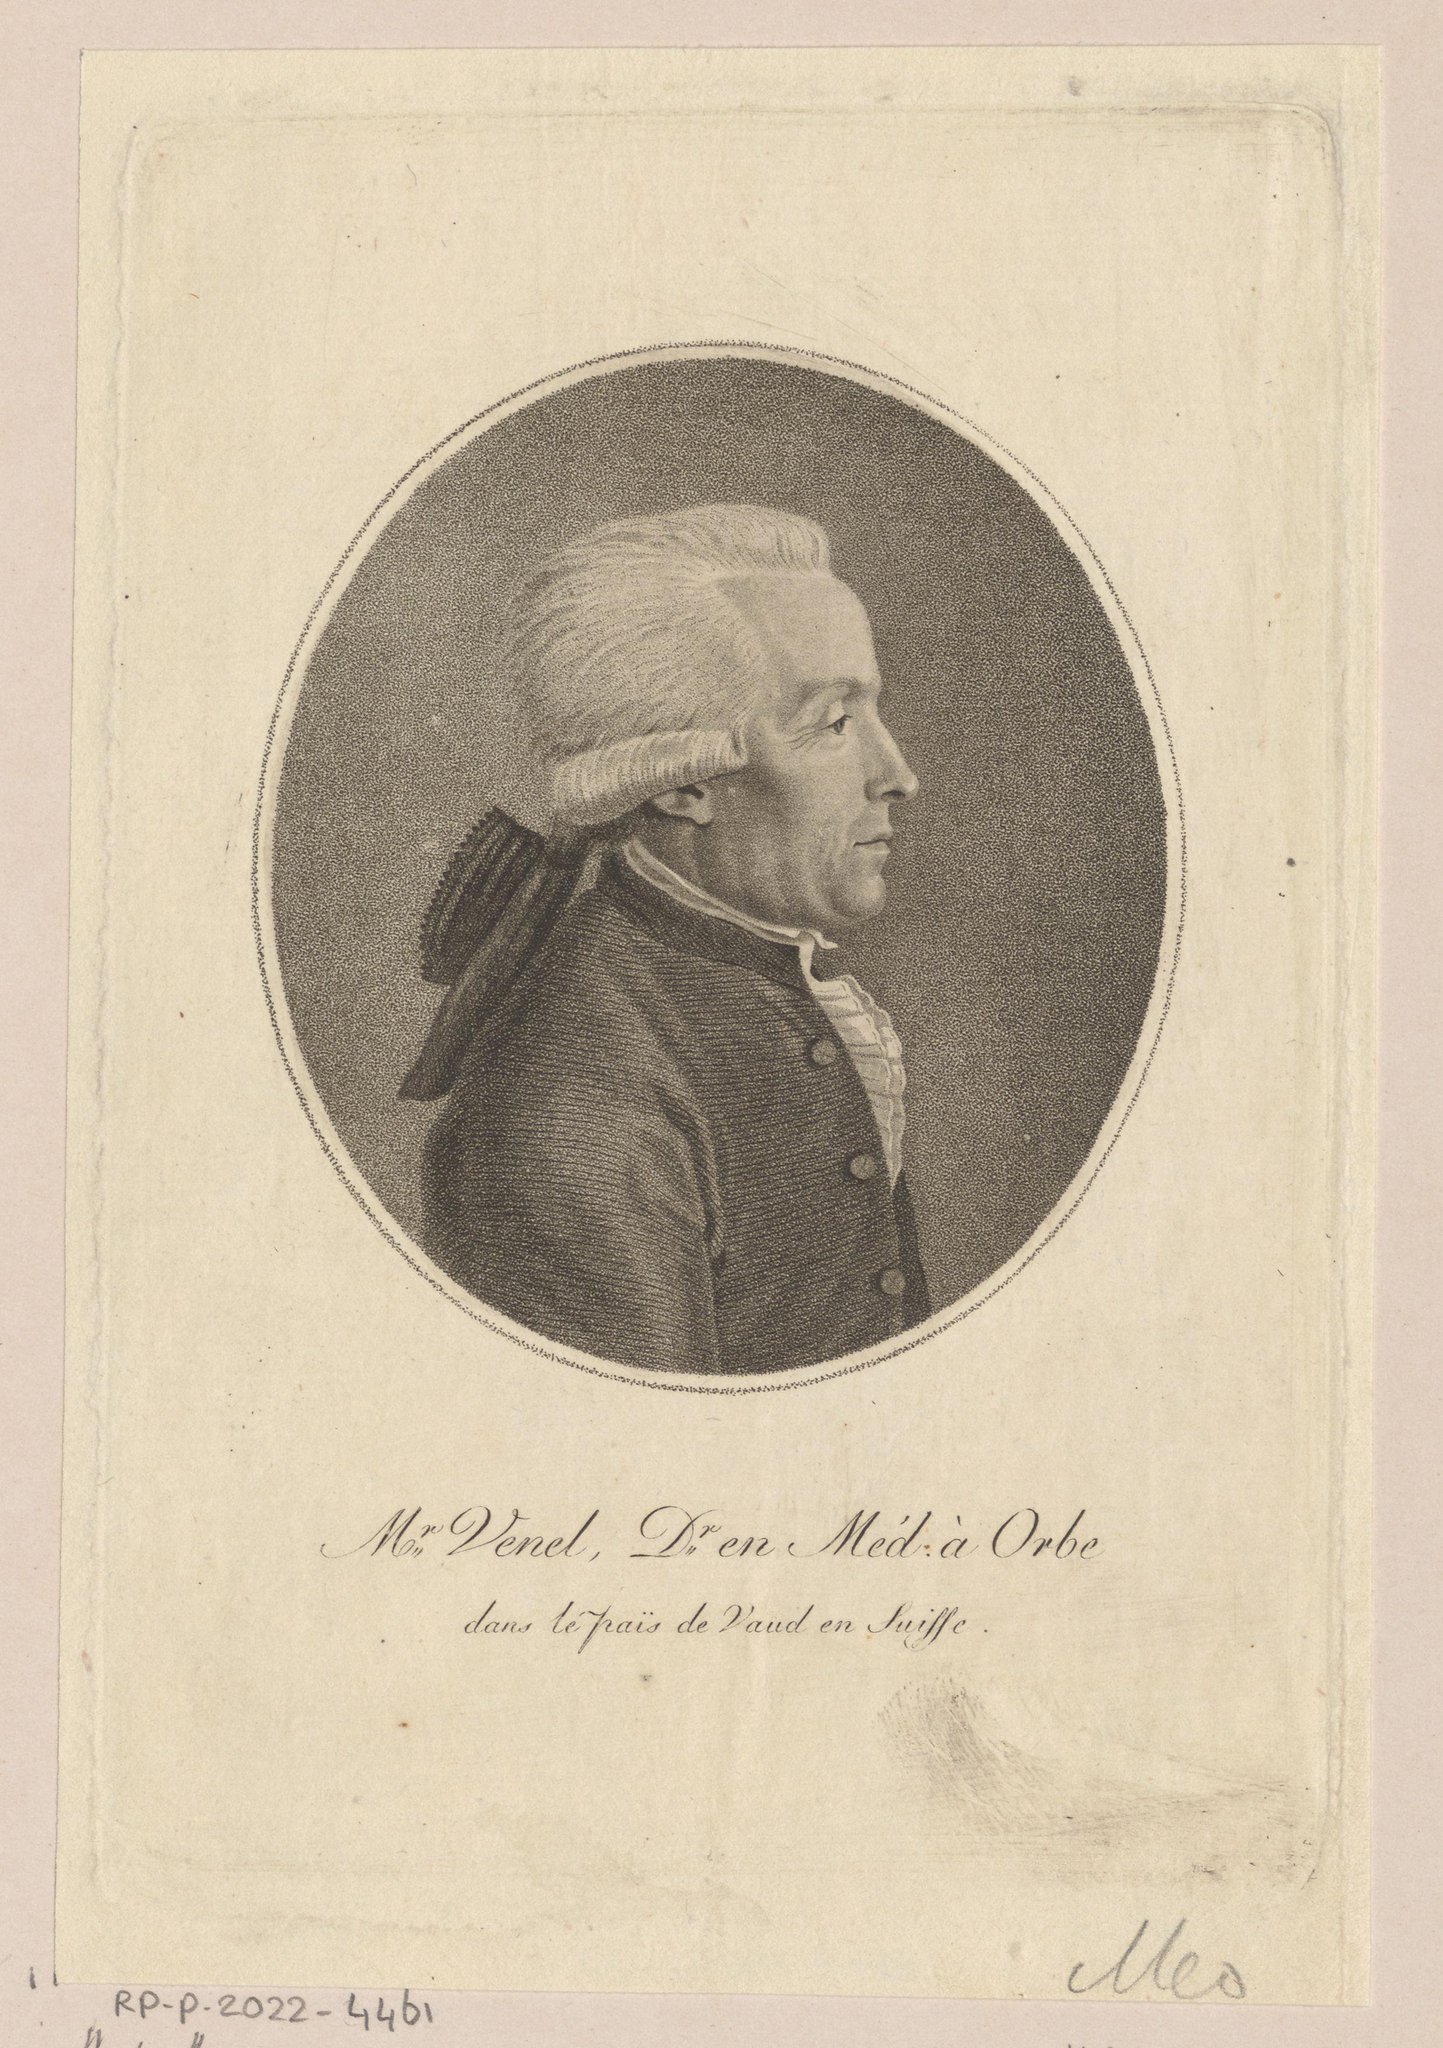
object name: print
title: Portret van Jean André Venel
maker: Anonymous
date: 1790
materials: paper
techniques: etching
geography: germany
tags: historical persons, physician, doctor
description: Prent waarschijnlijk uit: Journal von und für Deutschland, 1790, dl. 7.